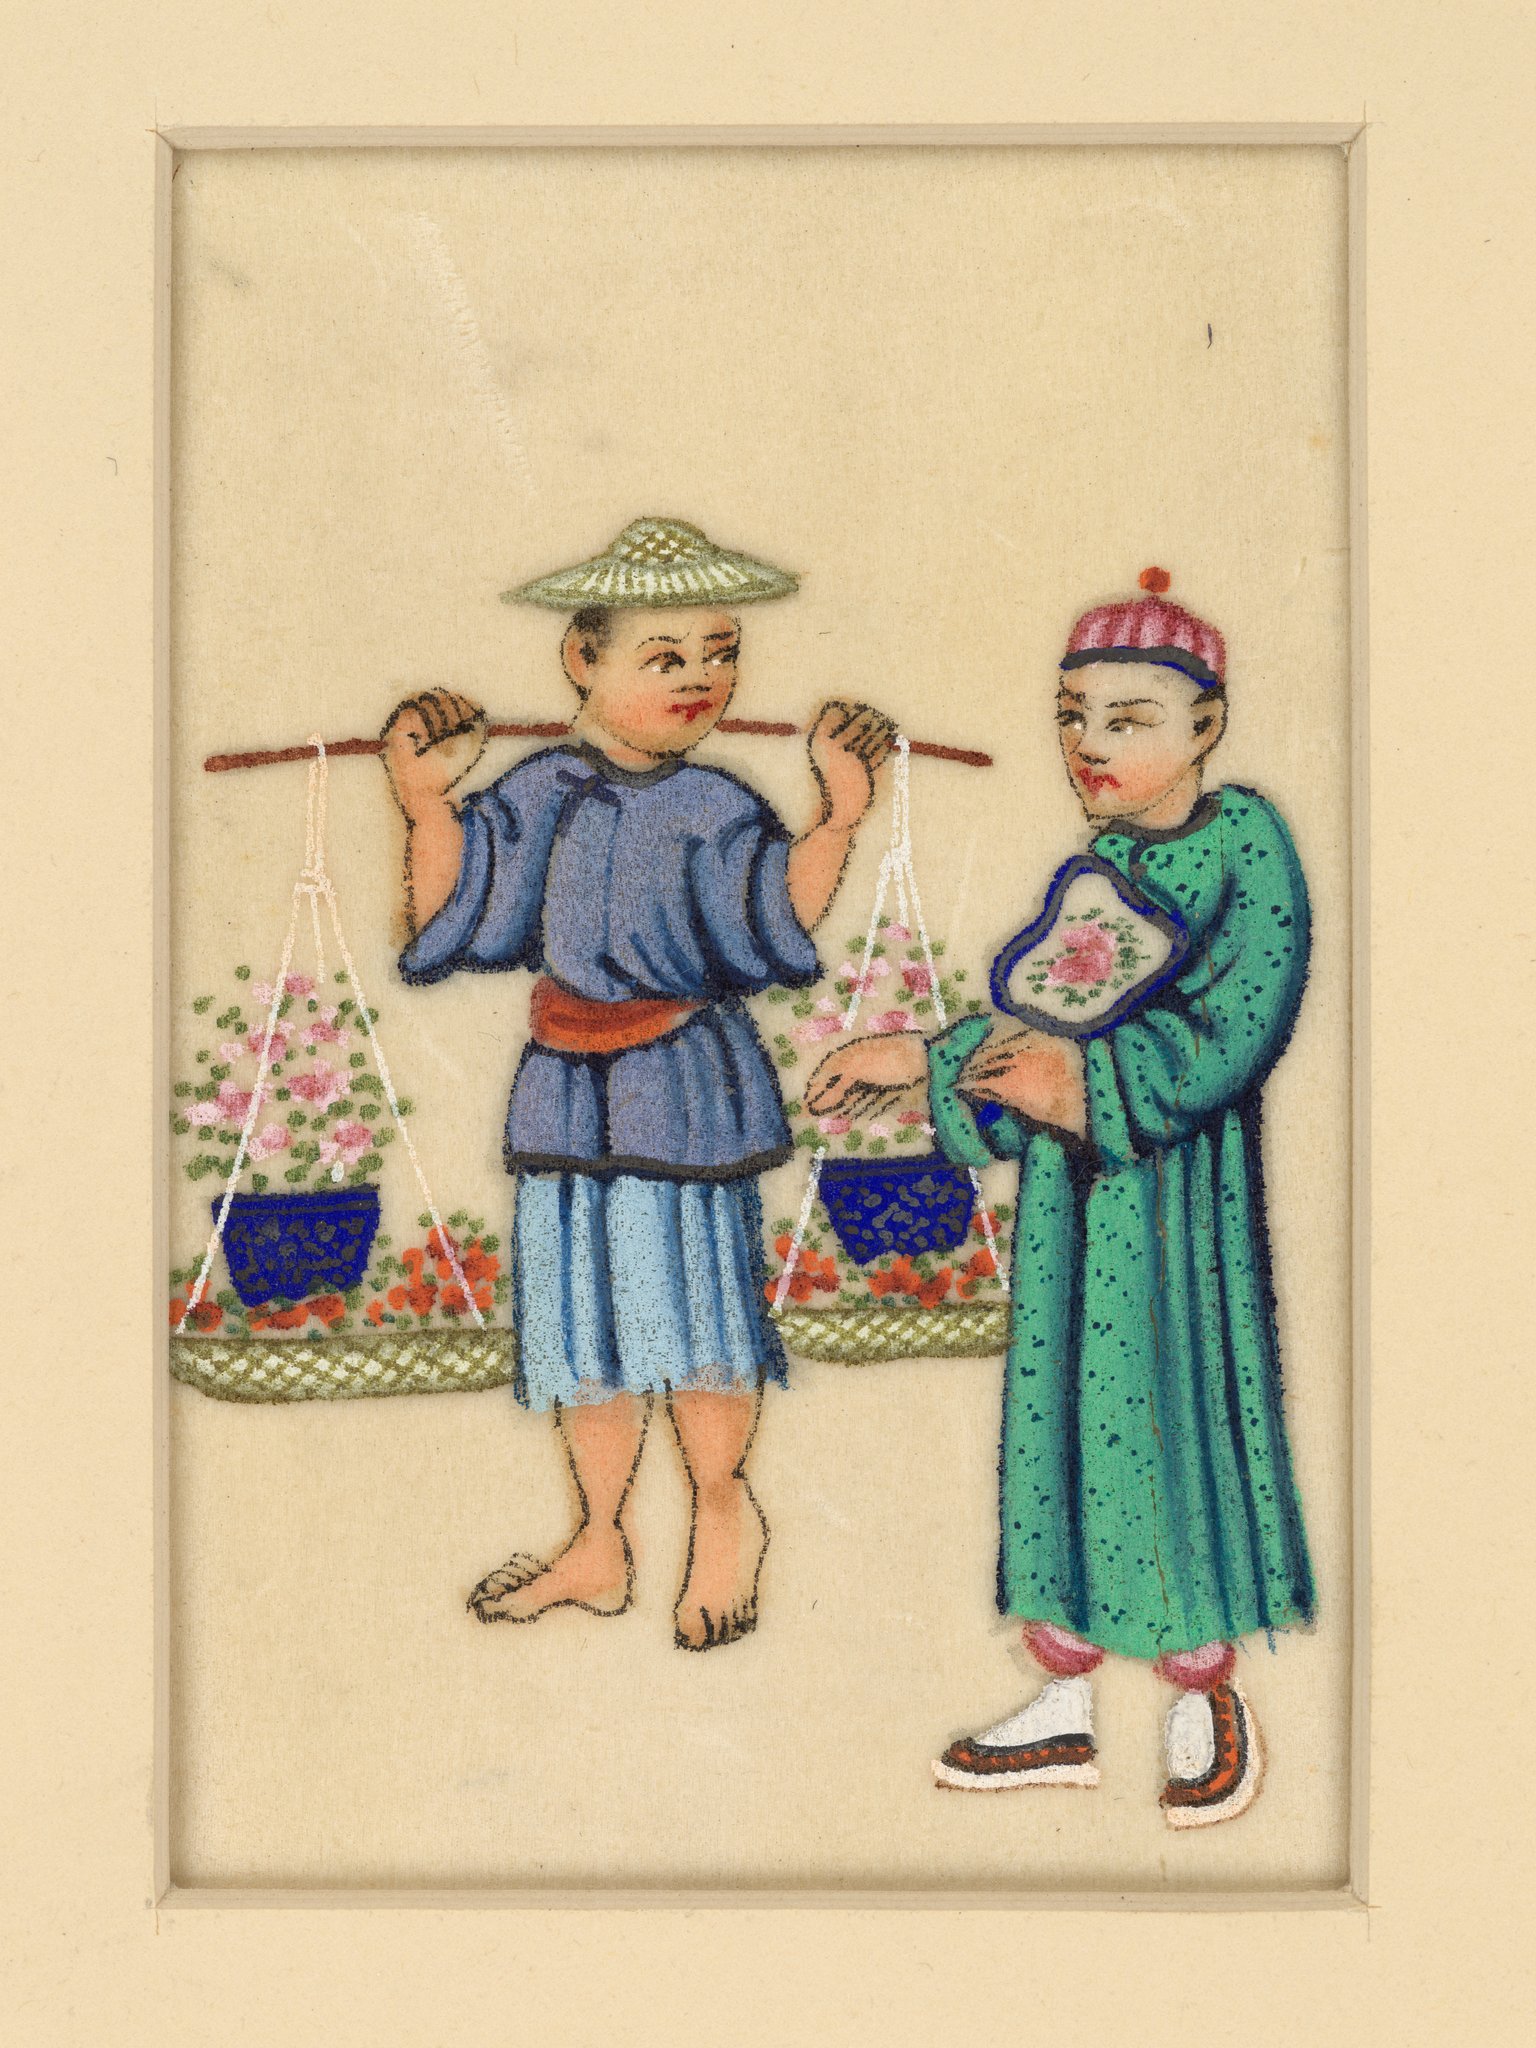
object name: leaf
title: Flower Vendor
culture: chinese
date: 1901-1933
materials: paper